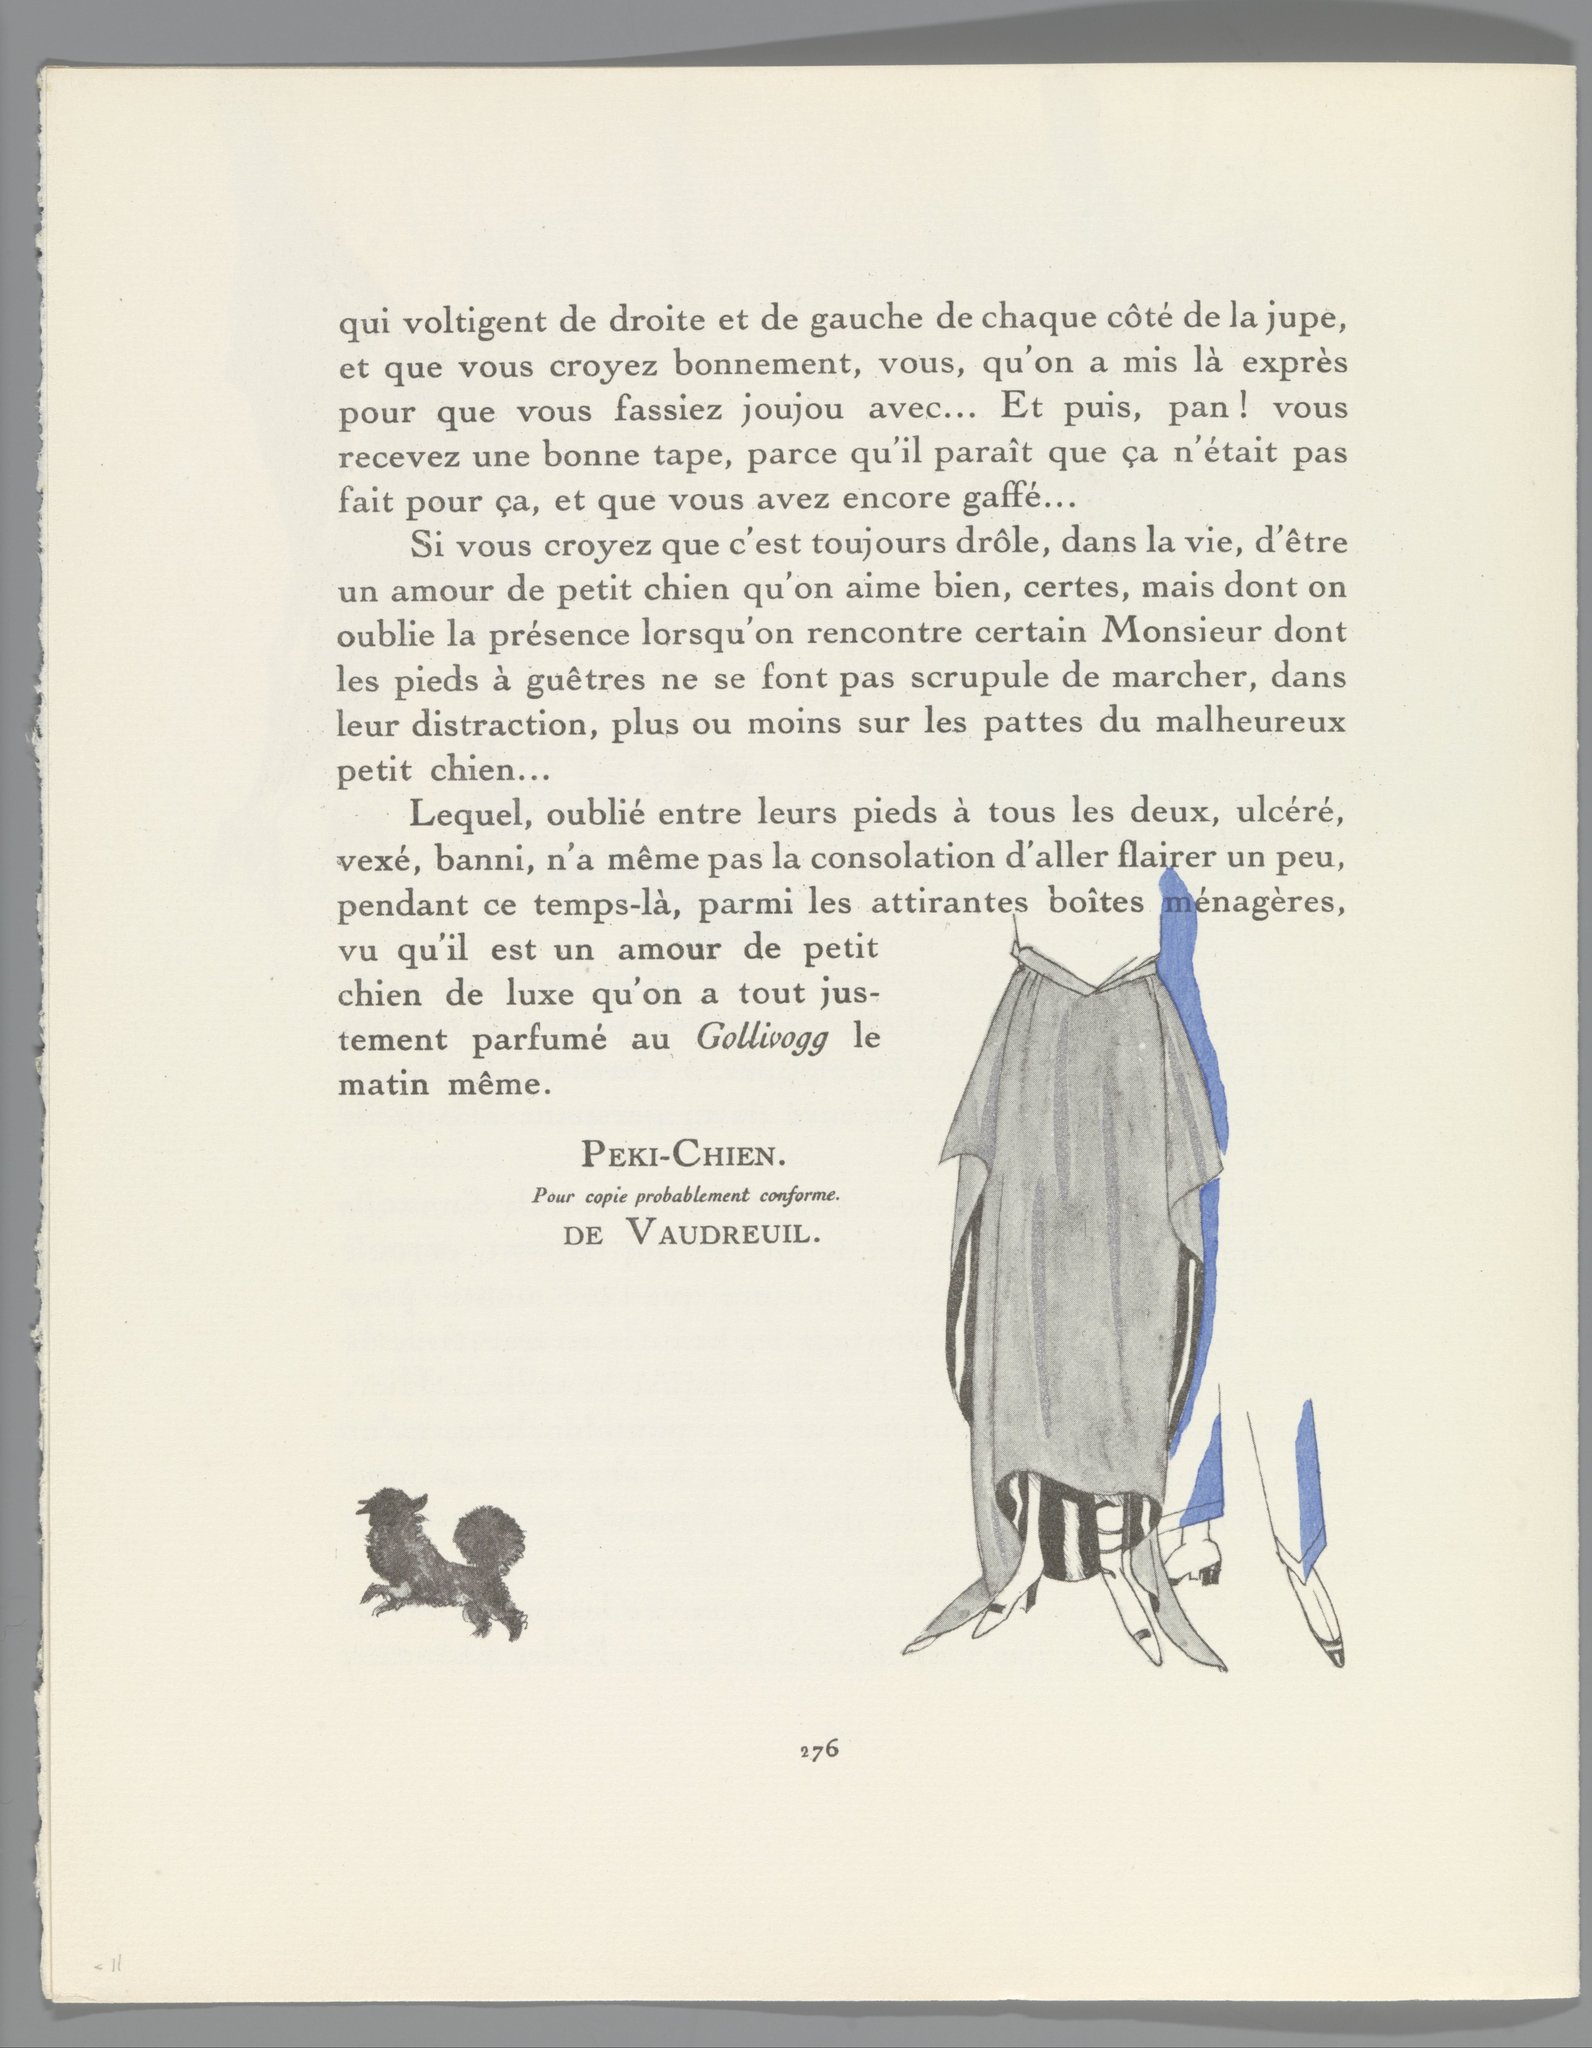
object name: fashion print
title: Gazette du Bon Ton, 1921 - No. 9, P. 276: Doléances (...)met illustratie van enkellange rok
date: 1921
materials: paper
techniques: letterpress printing, lithograph, photochemical processes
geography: geneva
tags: fashion plates, skirt (+ women's clothes), dog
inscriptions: date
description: Pag. 276: Doléances d'un amour de petit chien, touchant la déconcertante variété des bas de jupes de sa maitresse. Tekst over de variatie in onderranden van rokken. Met illustraties van enkellange rok waarachter een paar mannenbenen. Links een hondje dat wegloopt.